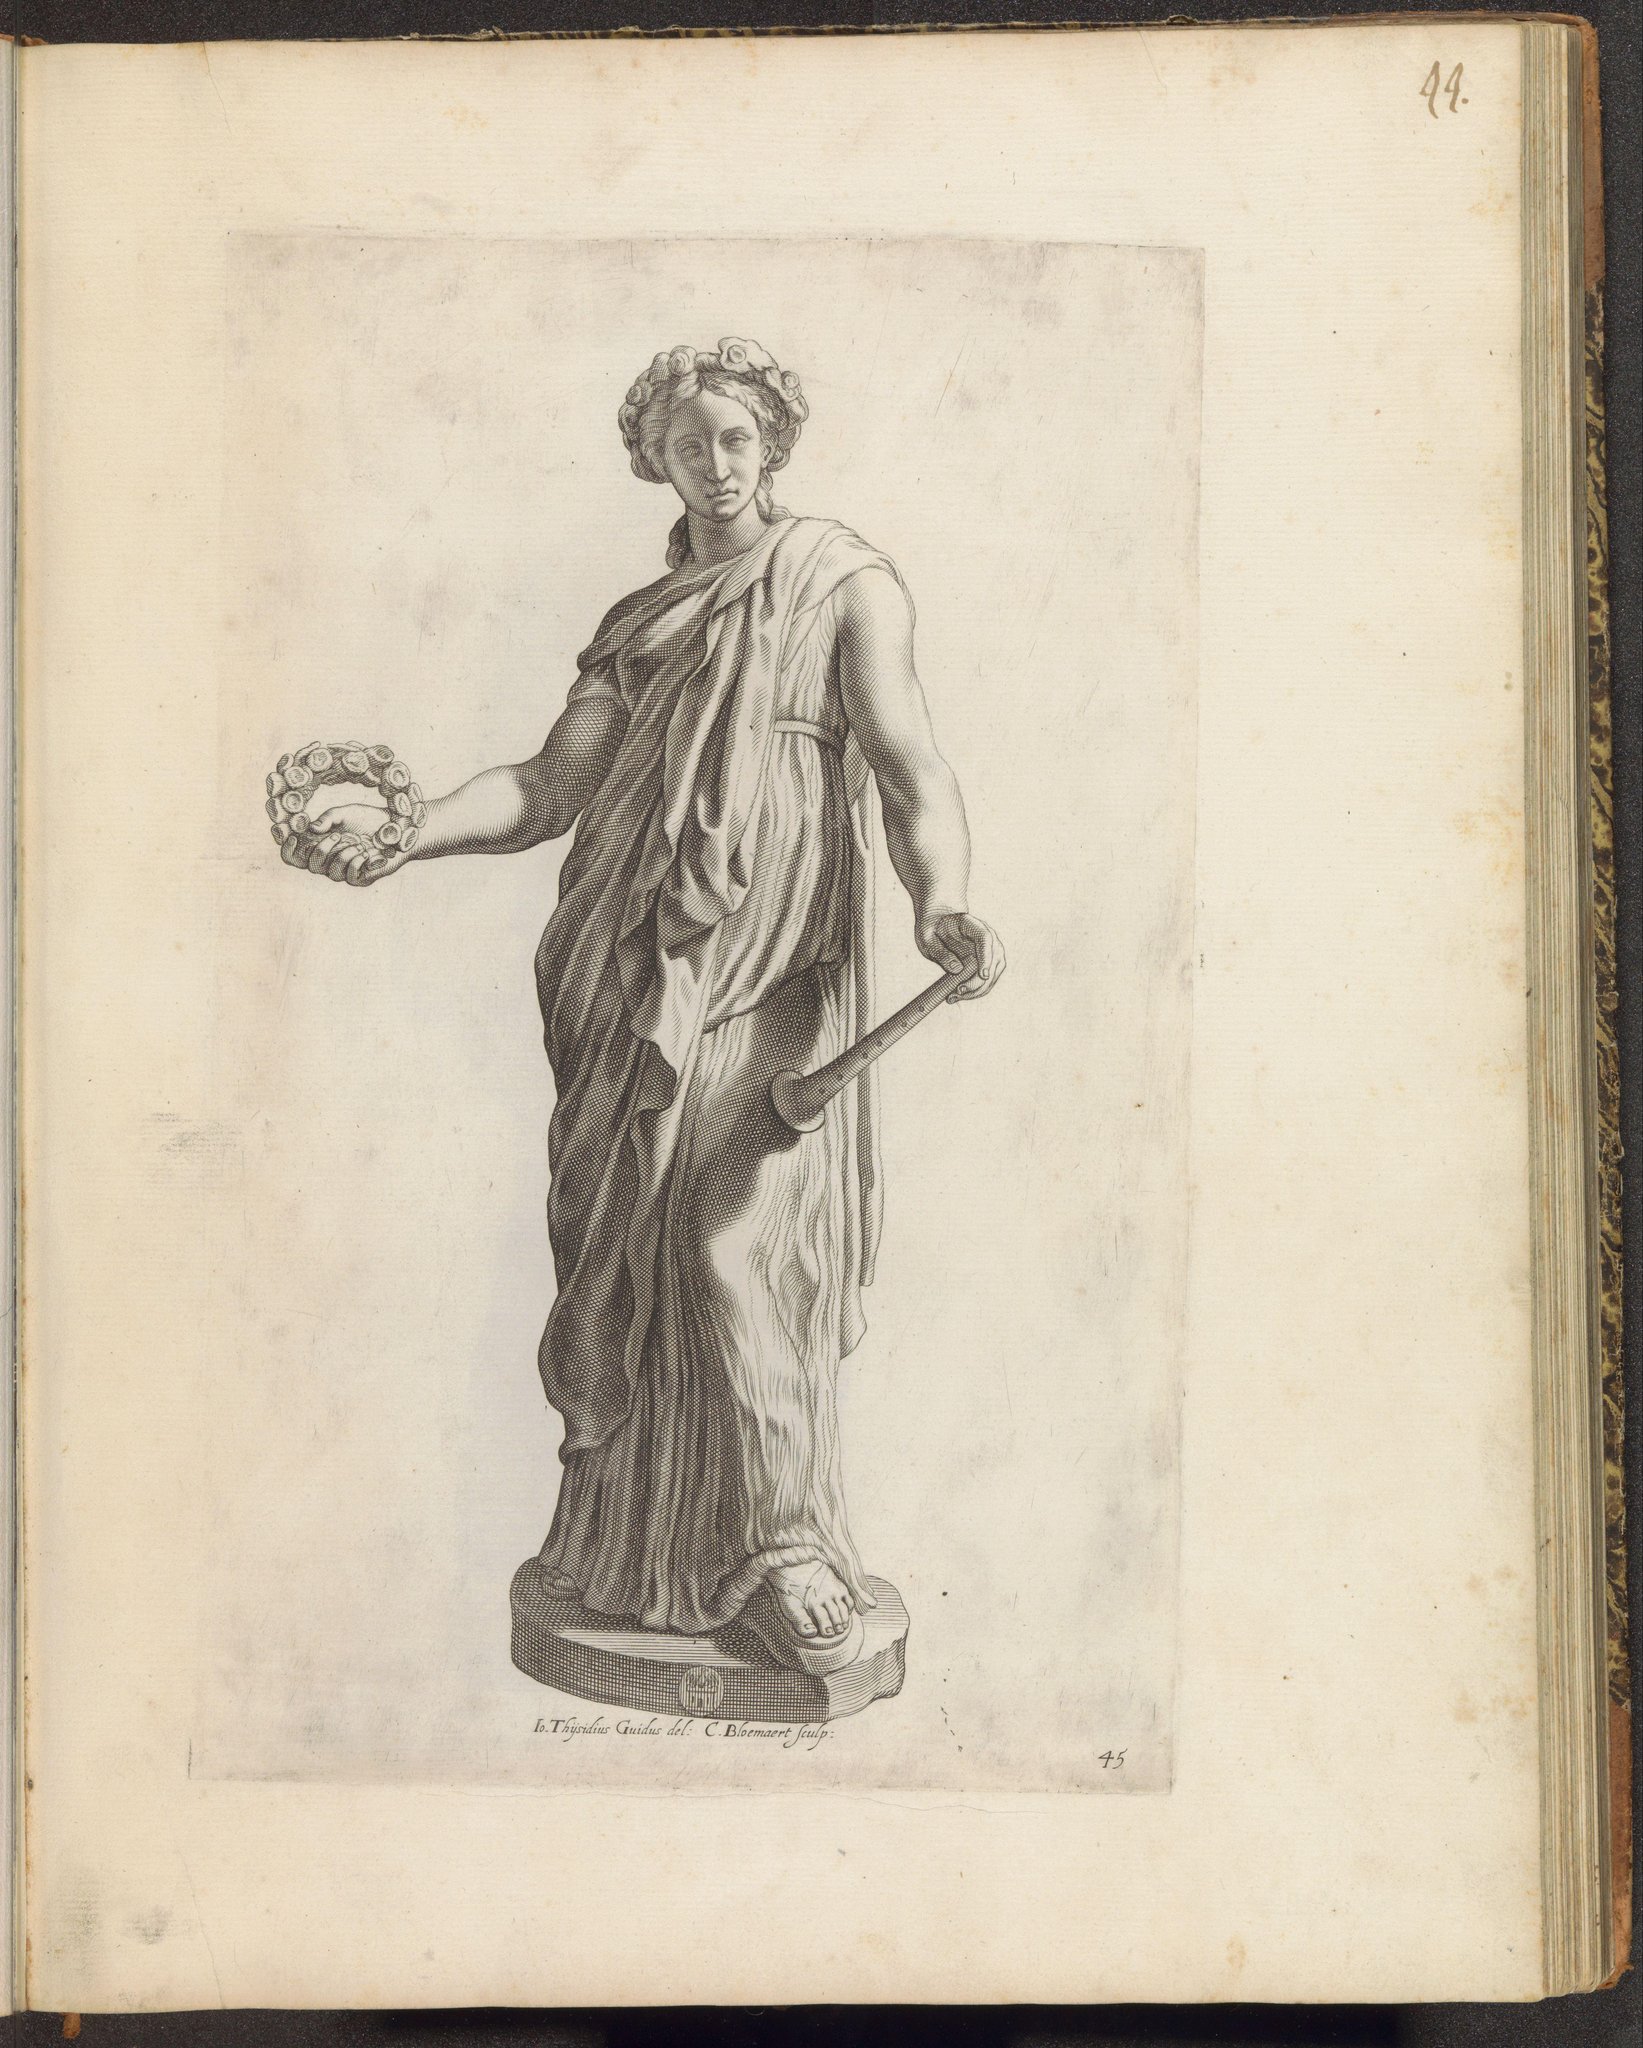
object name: album leaf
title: Galleria Giustiniana del Marchese Vincenzo Giustiniani I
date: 1636-1647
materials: paper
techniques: engraving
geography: rome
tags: piece of sculpture, reproduction of a piece of sculpture, (story of) flora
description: Beeld van Flora met een bloemenkrans op haar hoofd en in haar hand. In haar andere hand houdt zij een fluit. Op de basis het wapenschild van Vincenzo Giustiniani. Prent maakt deel uit van een album met een serie prenten naar de sculpturen in de verzameling in de Galleria Giustiniani te Rome.